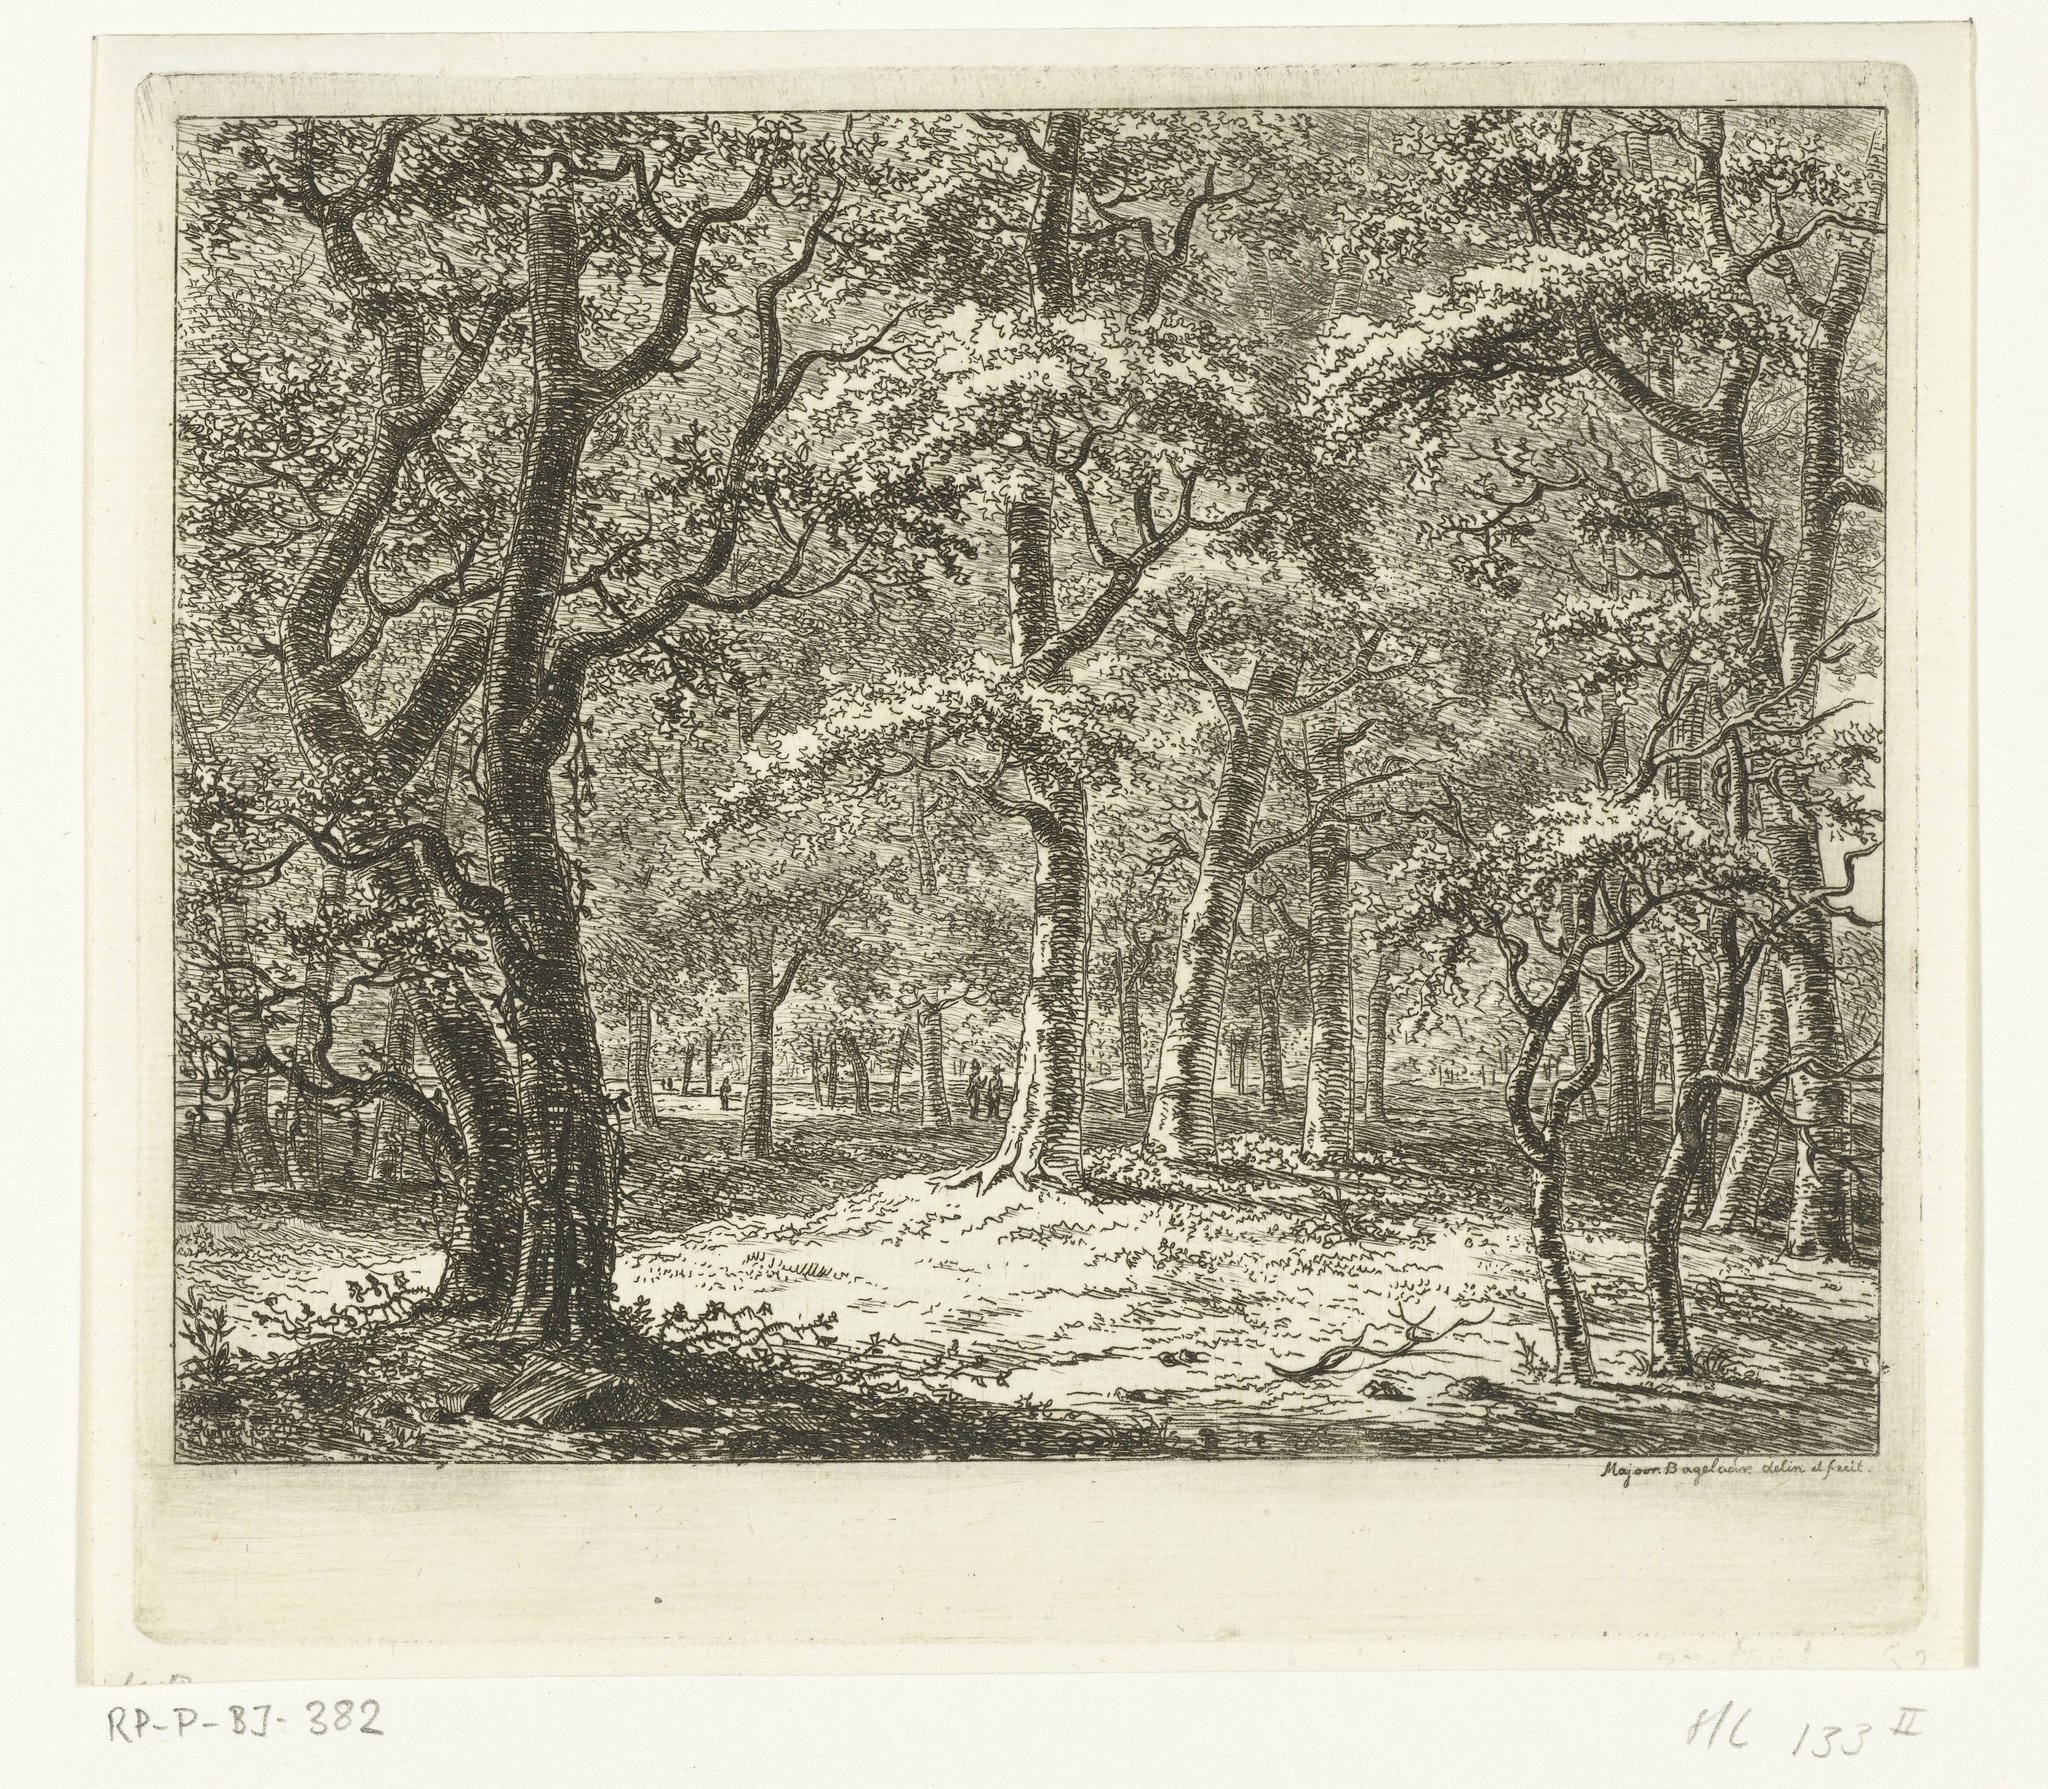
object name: print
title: Open plek in het bos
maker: ernst willem jan bagelaar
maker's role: draughtsman, print maker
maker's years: 1775-1837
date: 1798-1837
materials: paper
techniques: drypoint, etching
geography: netherlands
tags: glade, 'lichtung im wald'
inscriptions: collector's mark: Lugt 2228